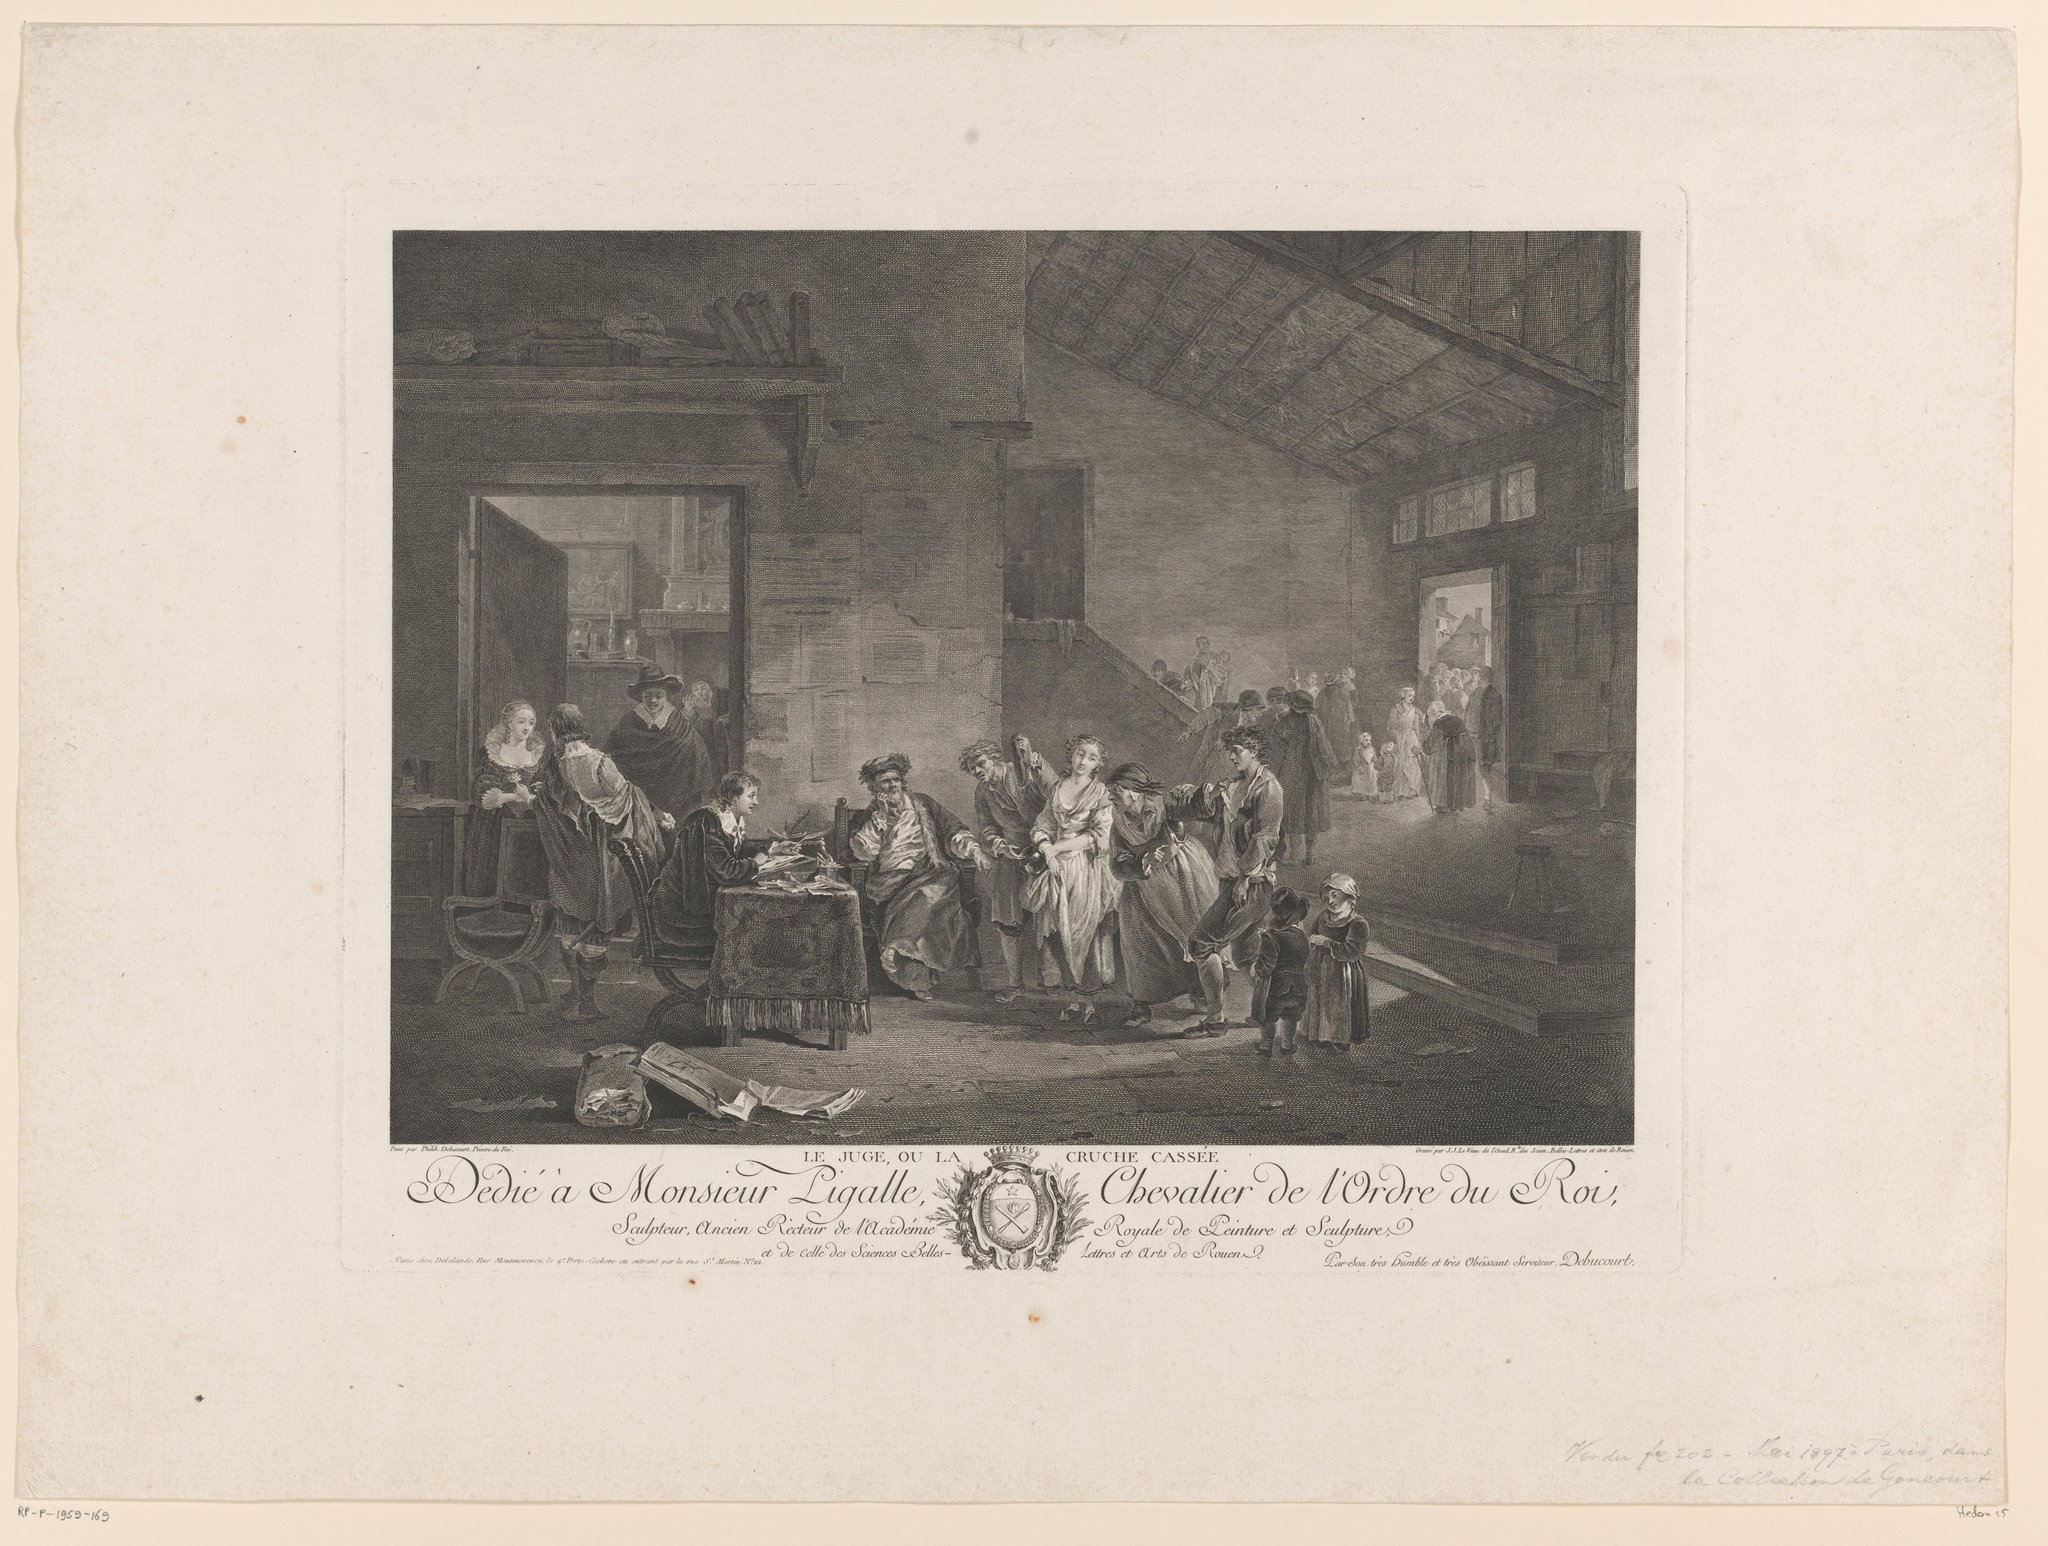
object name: print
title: Interieur met figuren voor een rechter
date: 1770-1786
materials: paper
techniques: engraving, etching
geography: paris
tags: administration of justice, trial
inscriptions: collector's mark: Lugt 2228, inscription: ‘bf (?) q1079 (?) f 35-’, inscription: ‘Vendue fr 202,- Mai 1897, dans/ la Collection Goncourt’, collector's mark: Lugt 2760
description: Interieur met een oude man met zijn dochter en een oude vrouw met haar zoon voor een rechter.